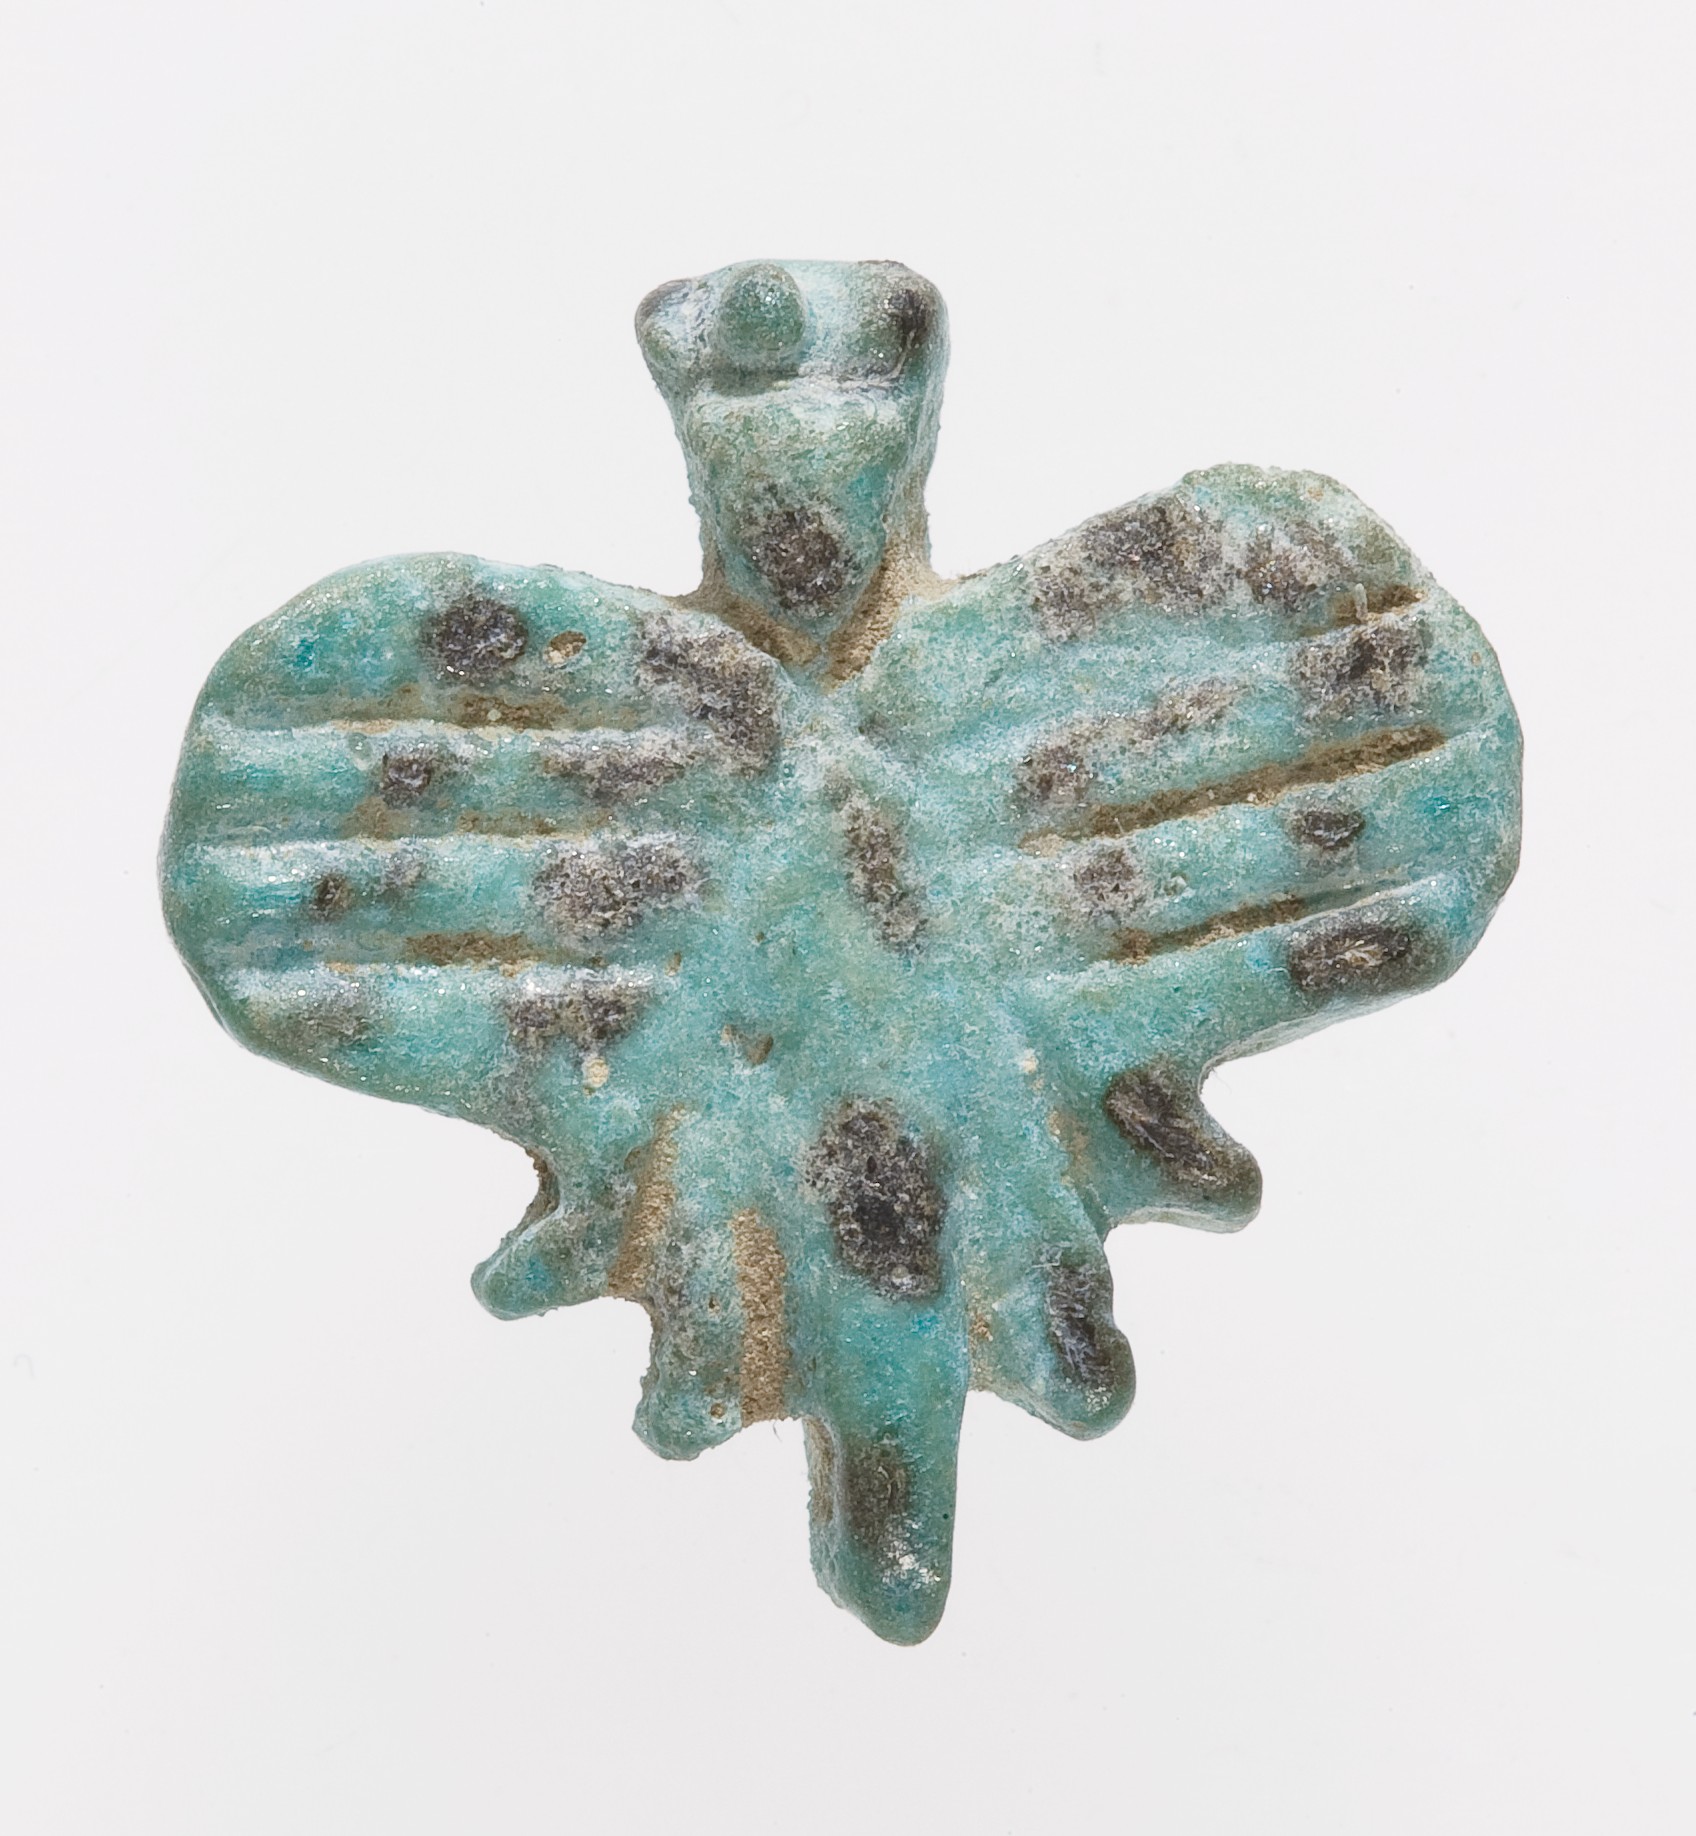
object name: amulet, butterfly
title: Butterfly amulet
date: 1981-1640 BCE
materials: faience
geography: egypt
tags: butterflies